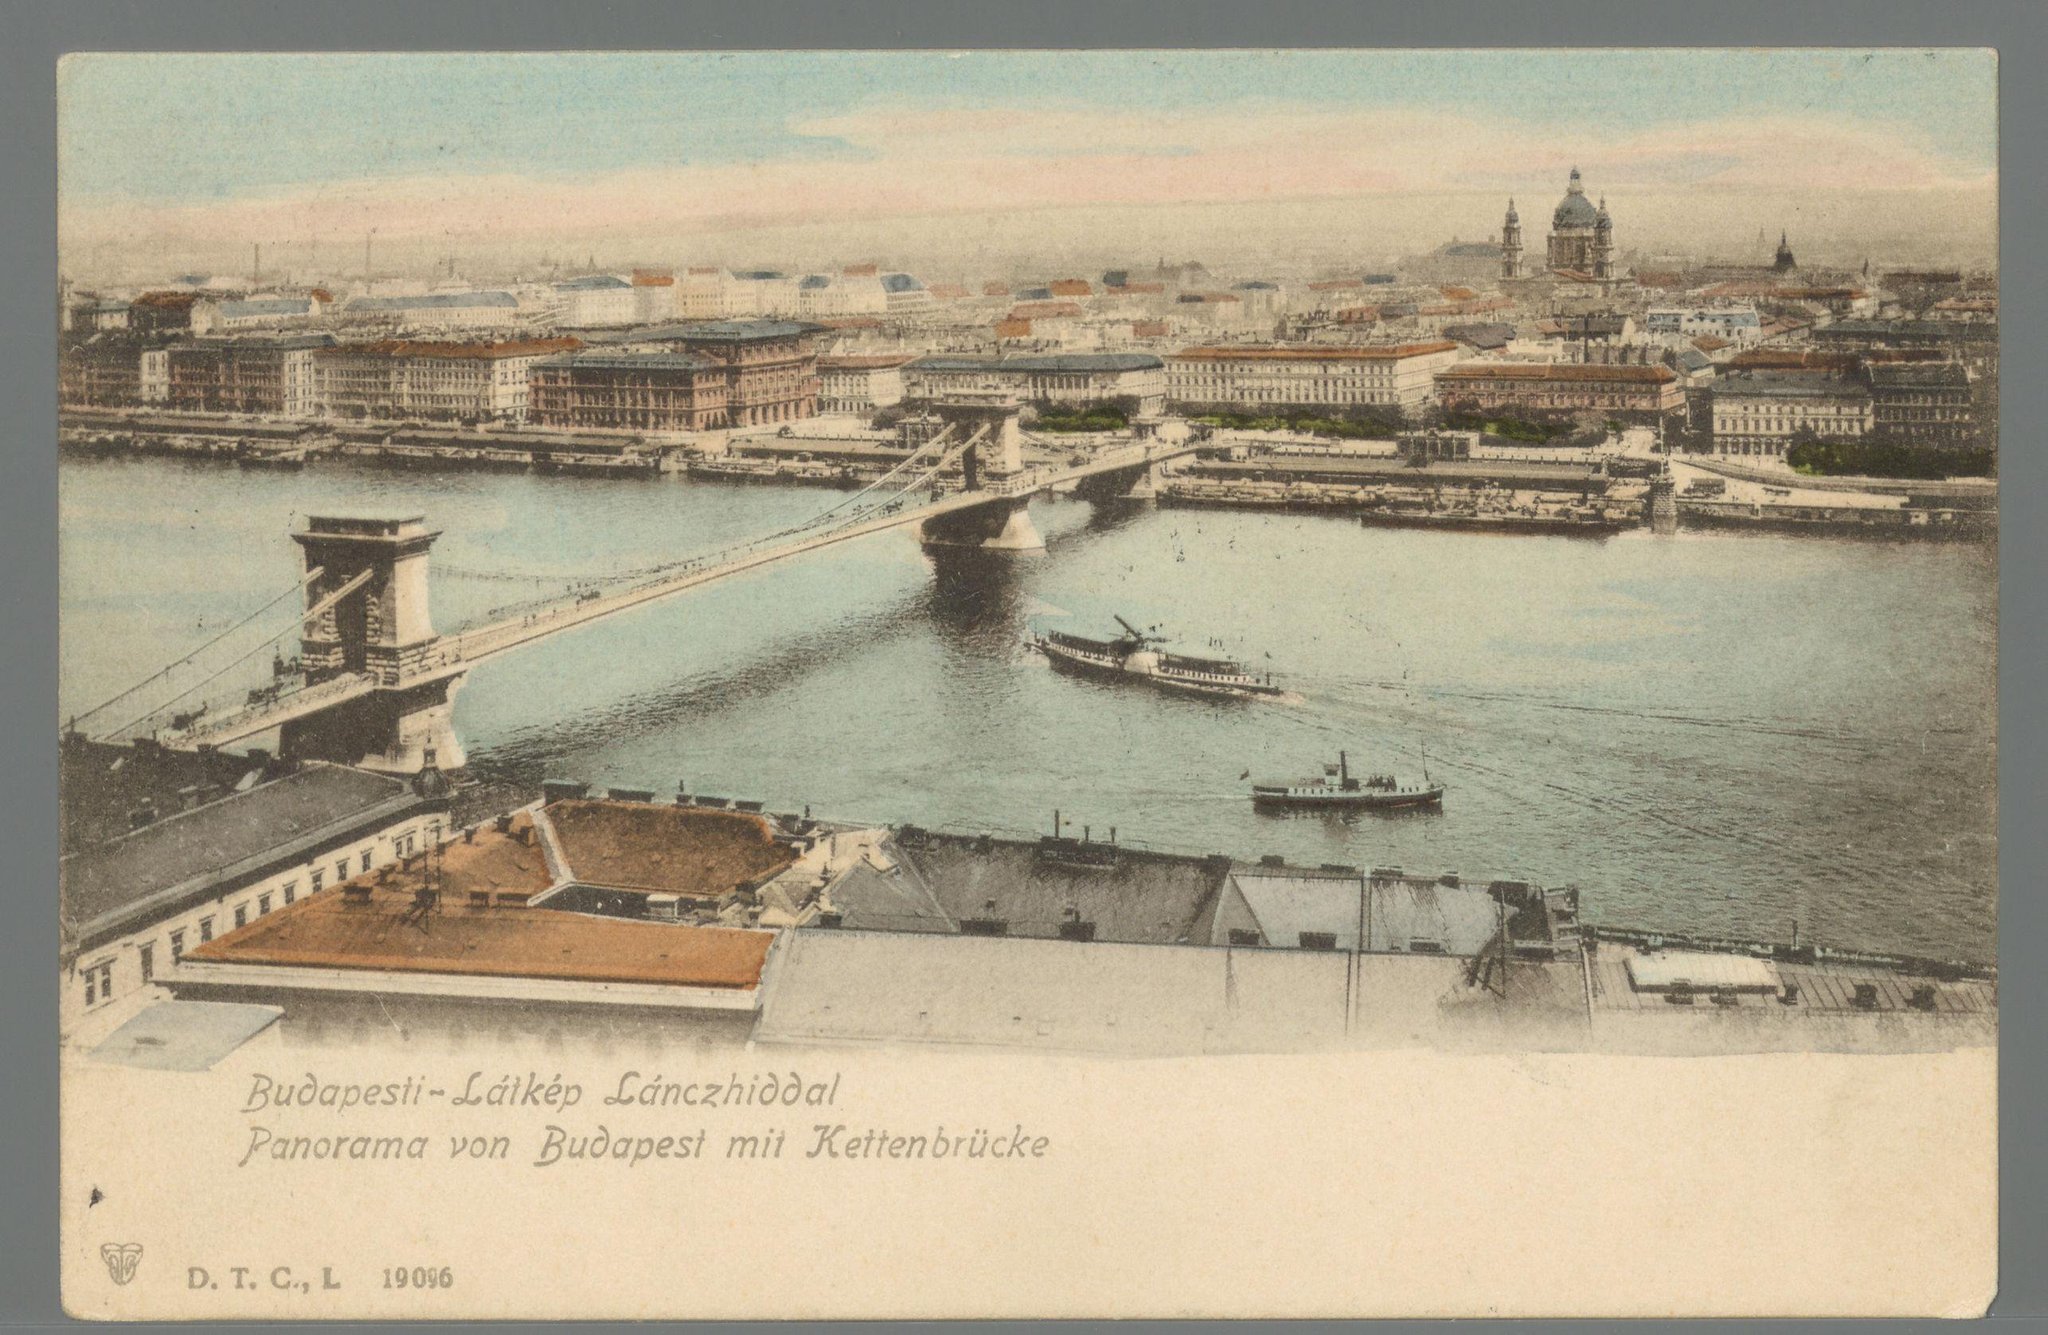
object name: ansichtkaart, prentbriefkaart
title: Budapesti - Látkép Lánczhiddal / Panorama von Budapest mit Kettenbrücke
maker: Anonymous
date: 1894-1903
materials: cardboard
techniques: photograph, hand coloring, writing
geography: budapest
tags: canals, waters (in city), bridge in city across river, canal, etc., prospect of city, town panorama, silhouette of city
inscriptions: postage stamp